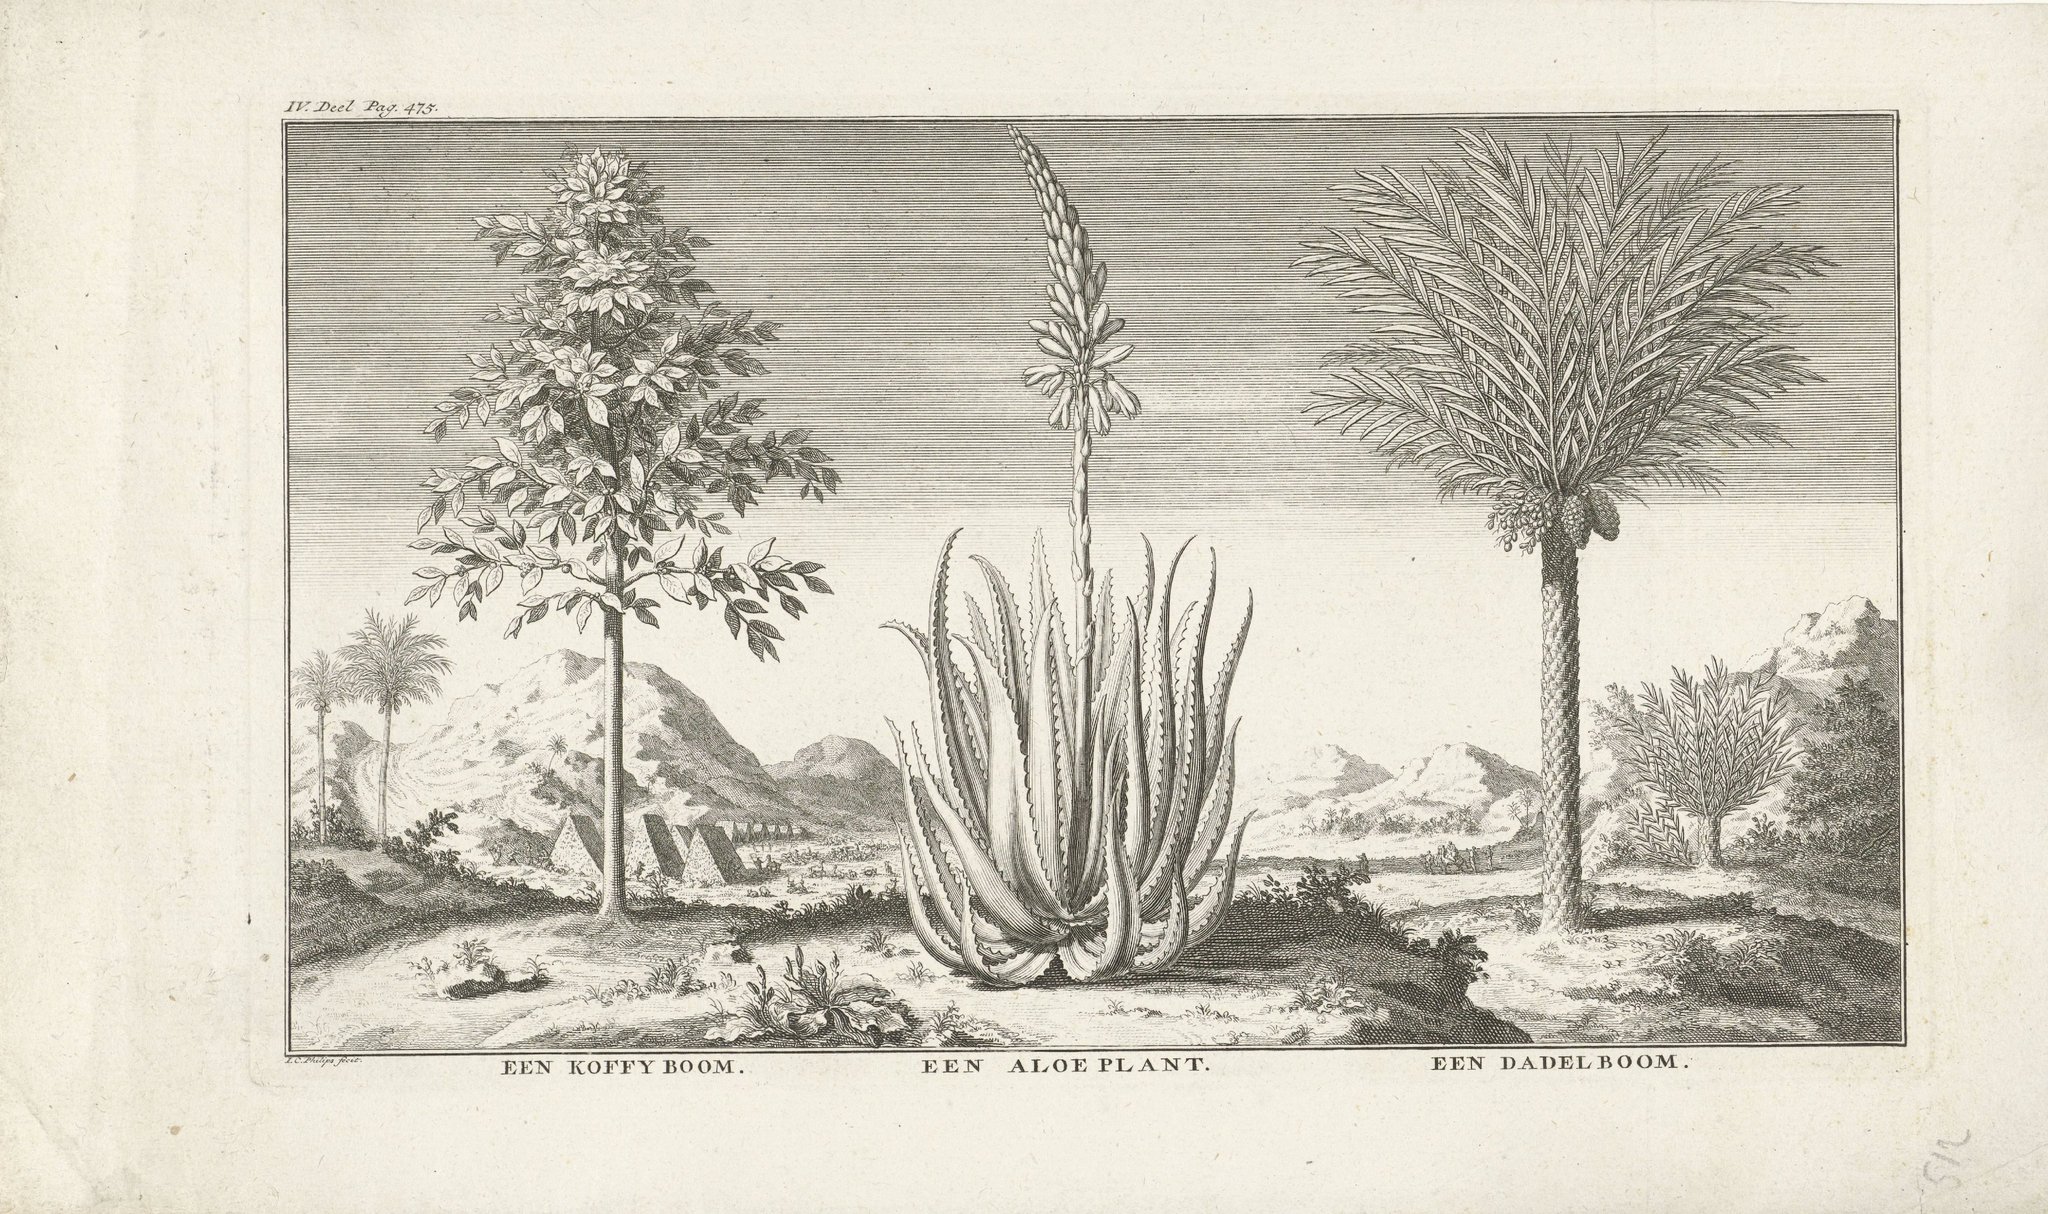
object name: print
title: Landschap met een groep bomen en planten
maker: jan caspar philips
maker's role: draughtsman, print maker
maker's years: 1700-1775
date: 1731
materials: paper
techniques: engraving, etching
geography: amsterdam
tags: trees: date-palm, groups of trees, plants and herbs: aloe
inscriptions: collector's mark: Lugt 2228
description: Illustratie uit: Salmon, Thomas. Hedendaagsche historie of Tegenwoordige staat van alle volkeren (...). IV. deel. Behelzende (...) Persia, Arabia, en het Asiatisch Tartaryen. [Vertaald uit het Engels door] M. van Goch. Amsterdam: Isaak Tirion, 1731.